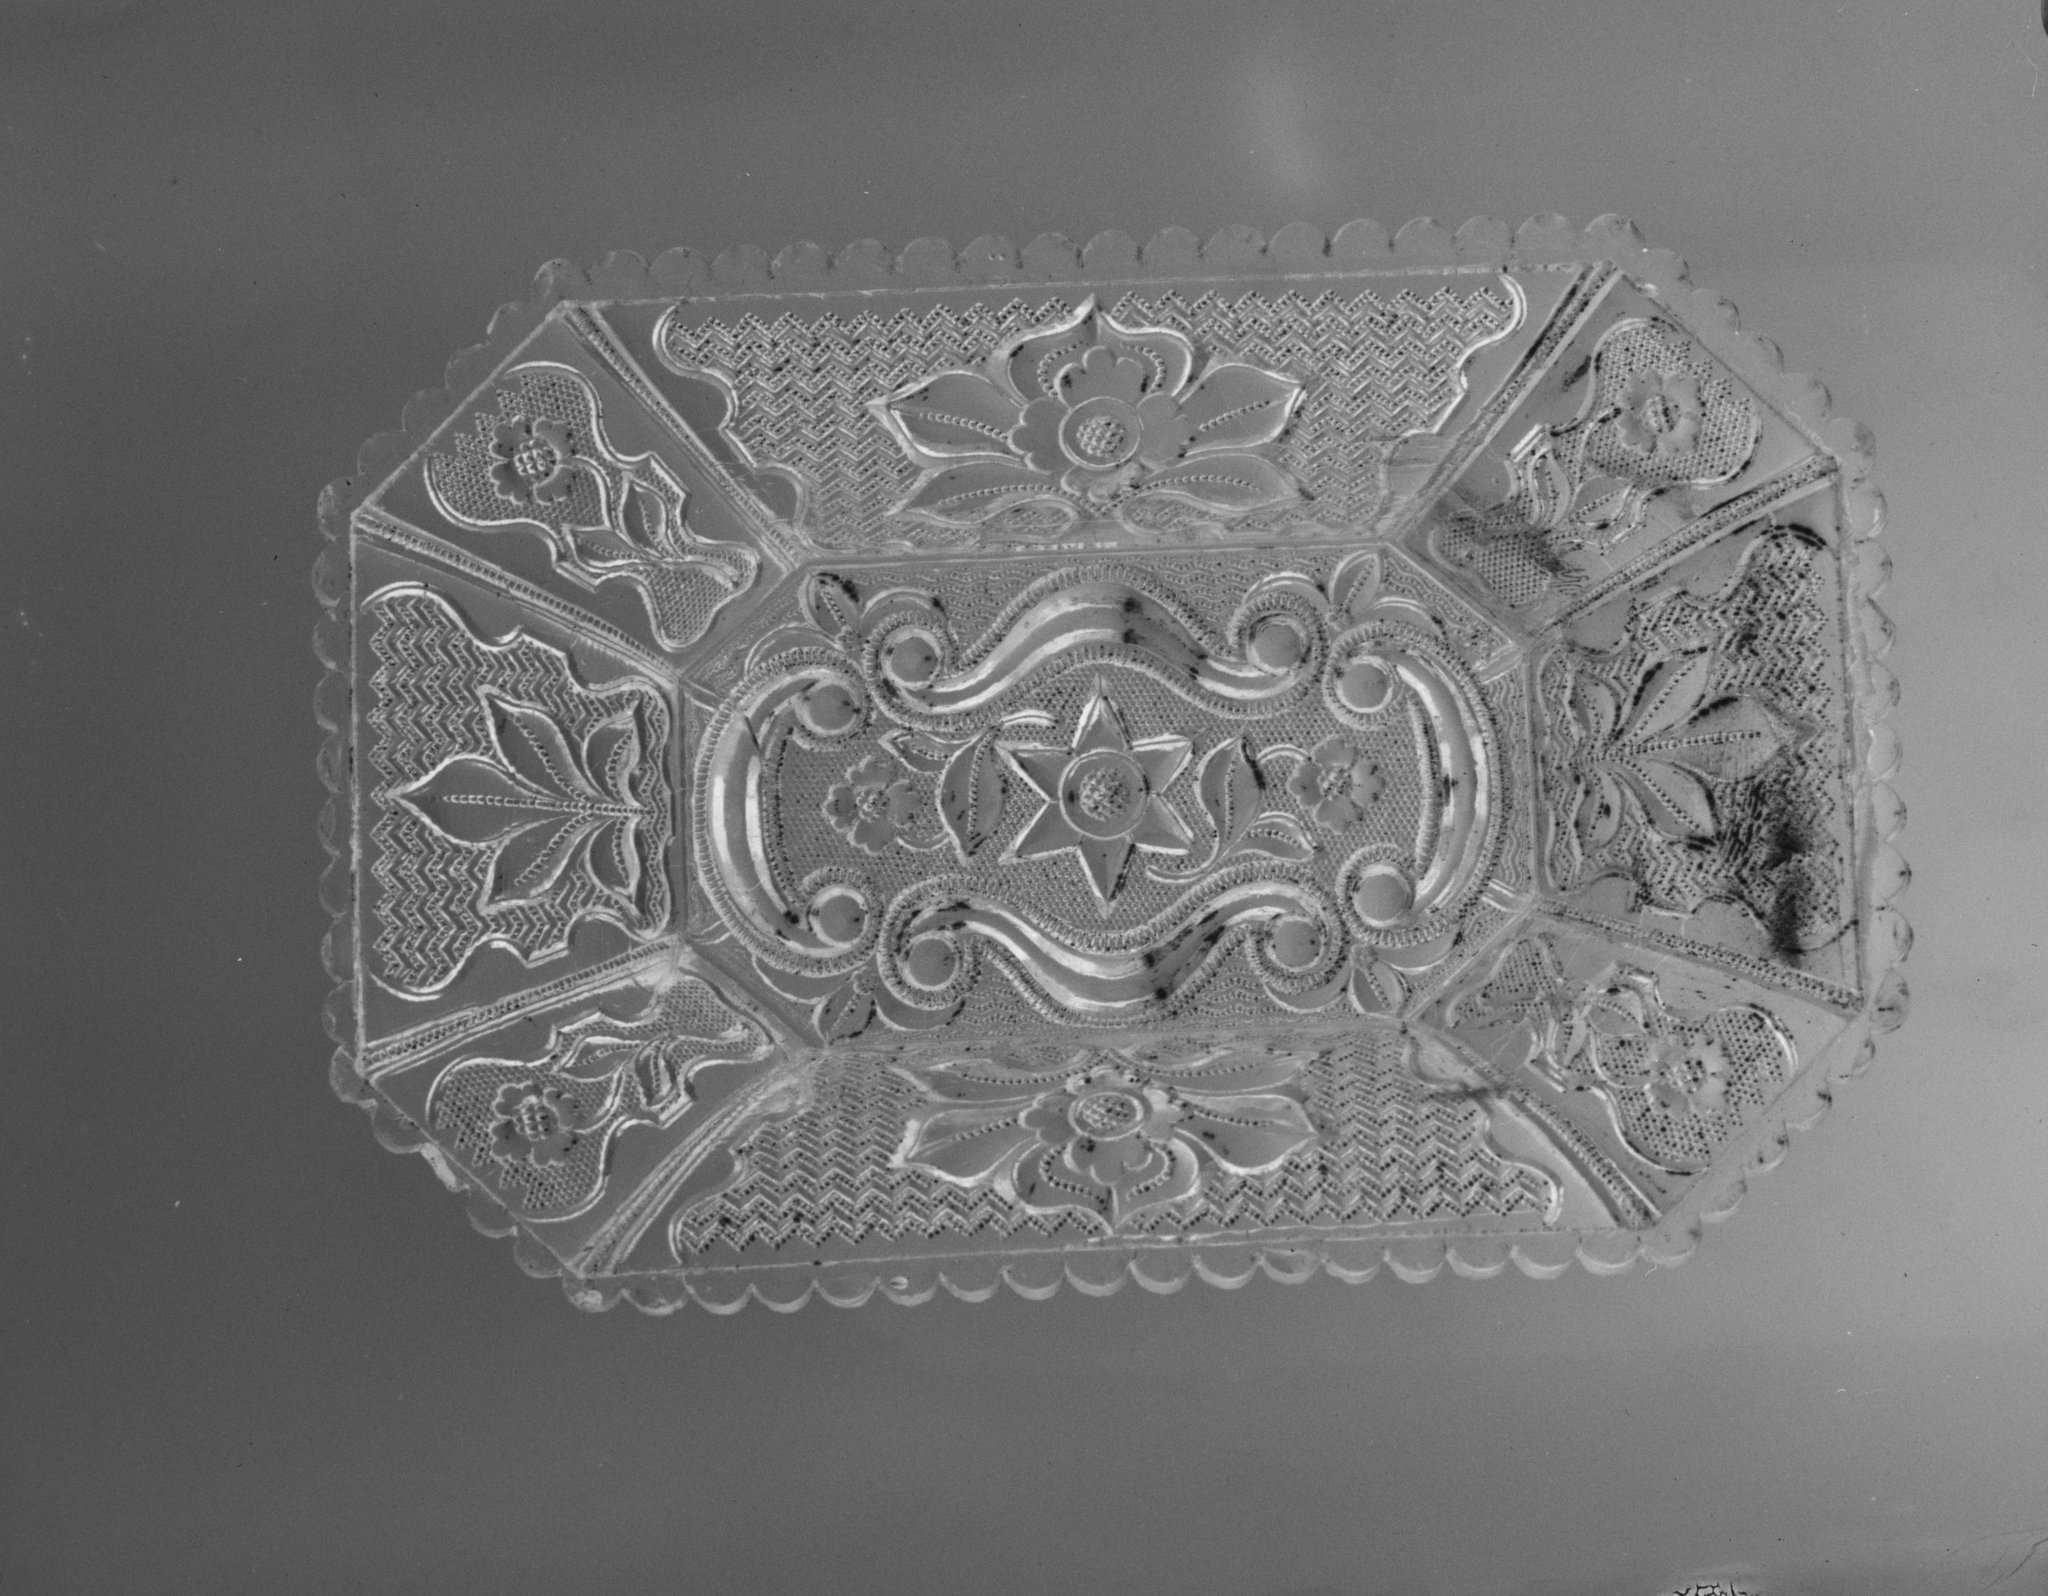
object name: dish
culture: american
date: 1835-1850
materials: glass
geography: united states